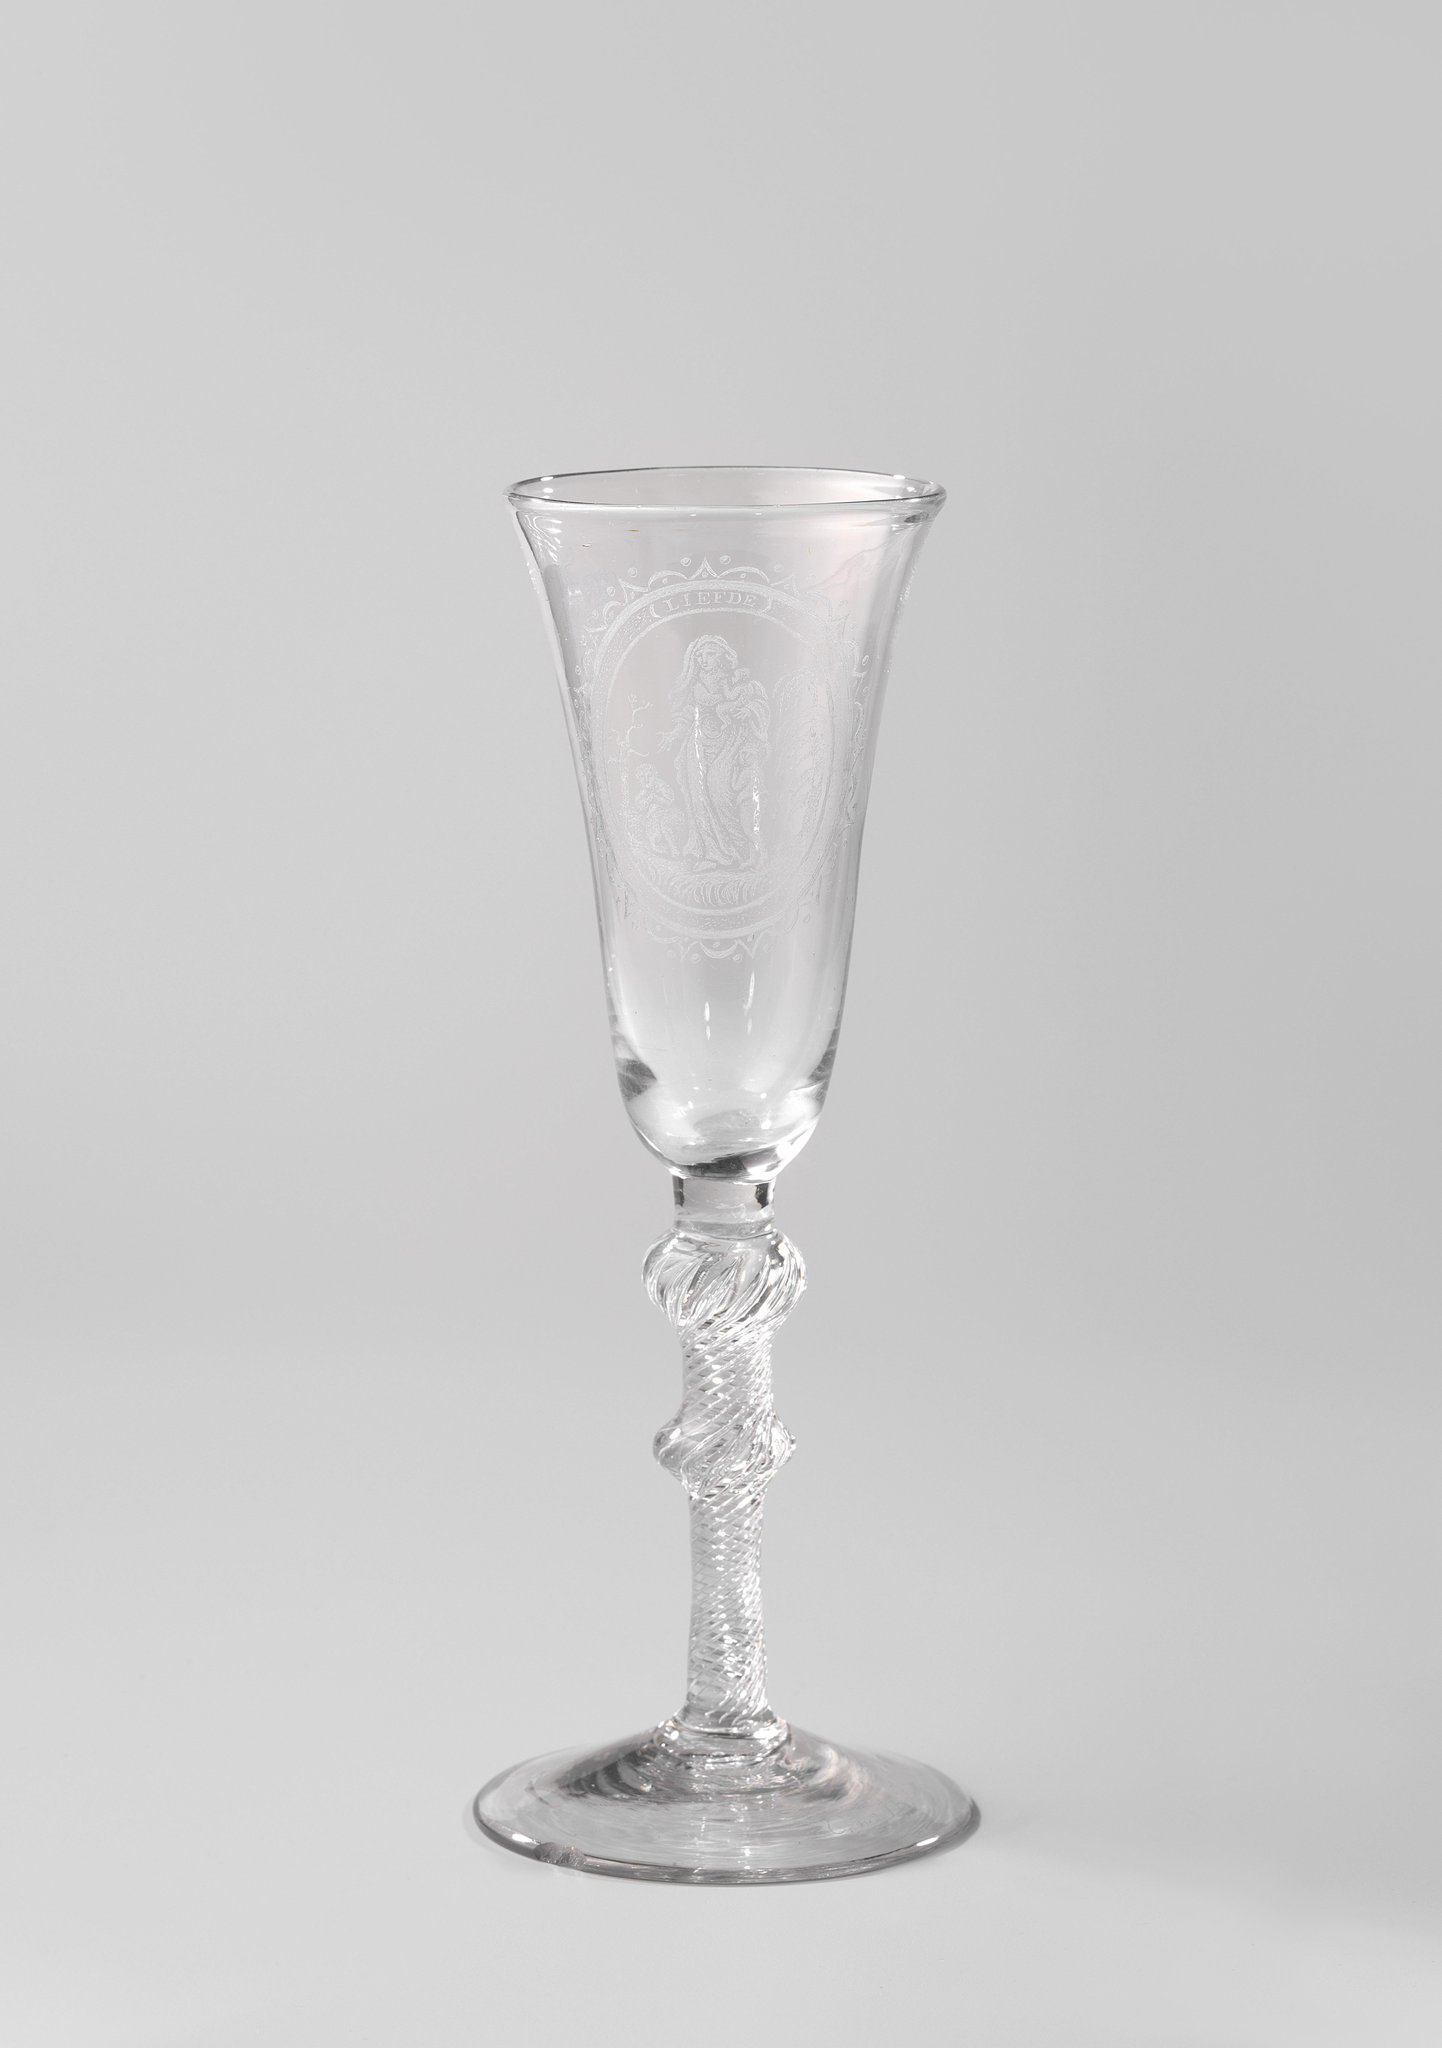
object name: goblet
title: Slingerglas met een personificatie van de Liefde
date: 1780-1810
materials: glass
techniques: diamond point engraving, glassblowing, engraving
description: Konische voet met pontilmerk. De stam opgebouwd uit een baluster en een nodus. In de stam een dubbele luchtslinger. Klokvormige kelk met afgeronde onderzijde. Op de kelk is in een ovaal medaillon Charitas afgebeeld, voorgesteld door een staande vrouw met een kind aan haar borst en een kind naast haar. In de rand van het medaillon staat boven de vrouw 'LIEFDE'. links van het medaillon is een vlinder.